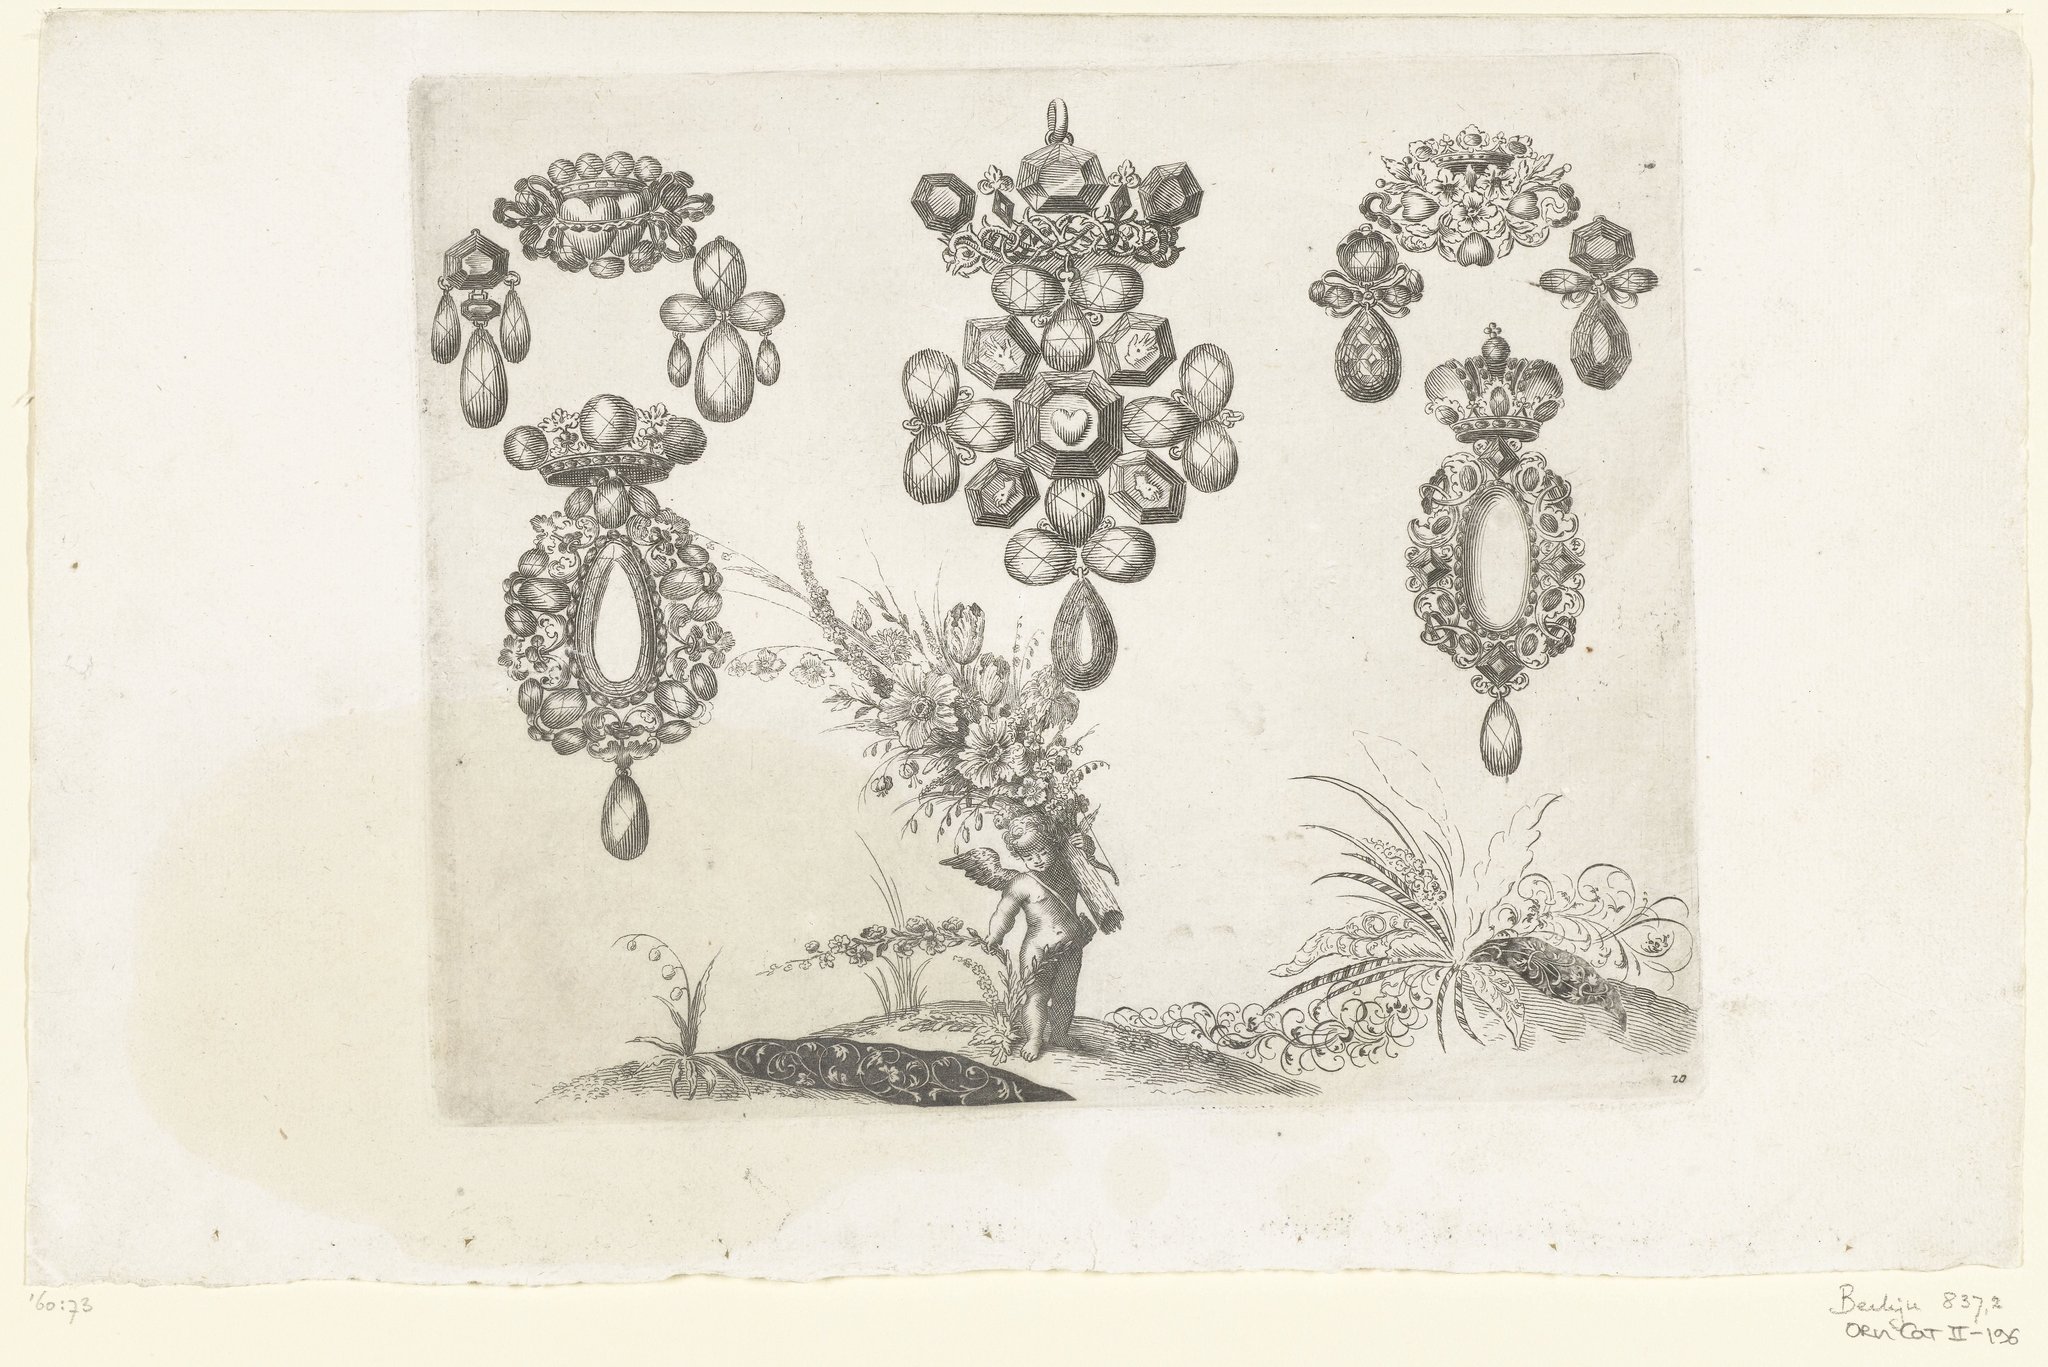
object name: ornament print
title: Negen broches en oorbellen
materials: paper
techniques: engraving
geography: amsterdam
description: Onderaan loopt een putto met een boeket bloemen.